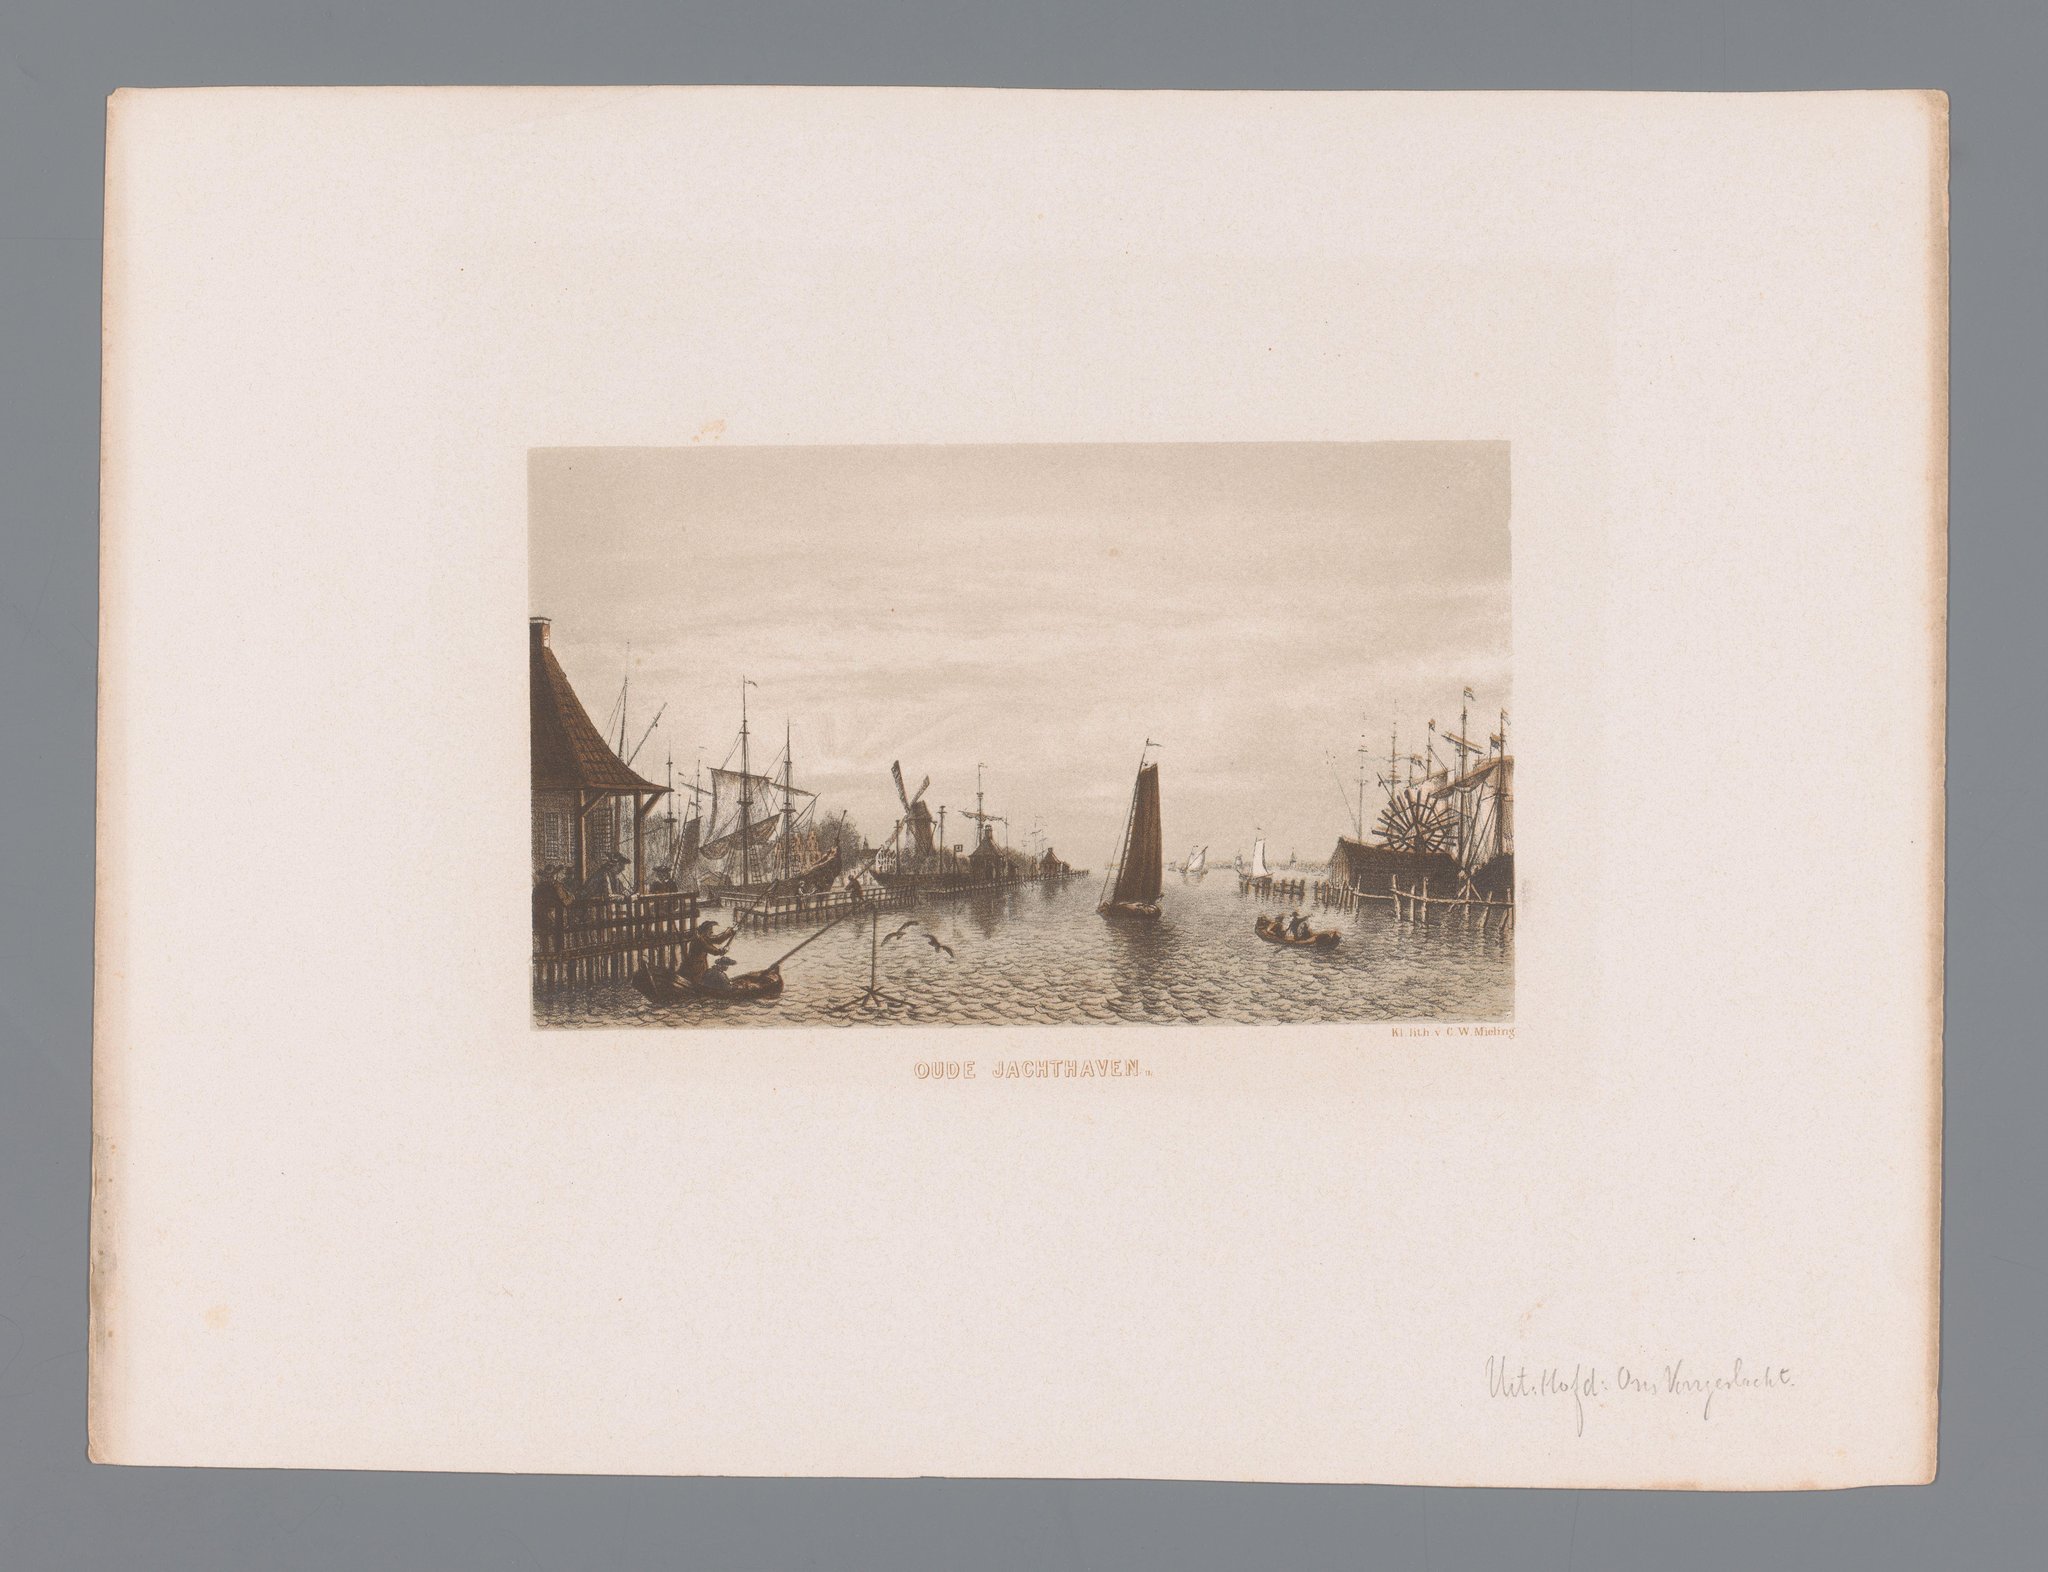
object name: print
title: Oude jachthaven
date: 1864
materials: paper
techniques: tone lithography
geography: the hague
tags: harbour, sailing-ship, sailing-boat, windmill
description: In het midden varen een zeil- en een roeiboot. Links en rechts liggen zeilschepen voor anker. Links een windmolen.